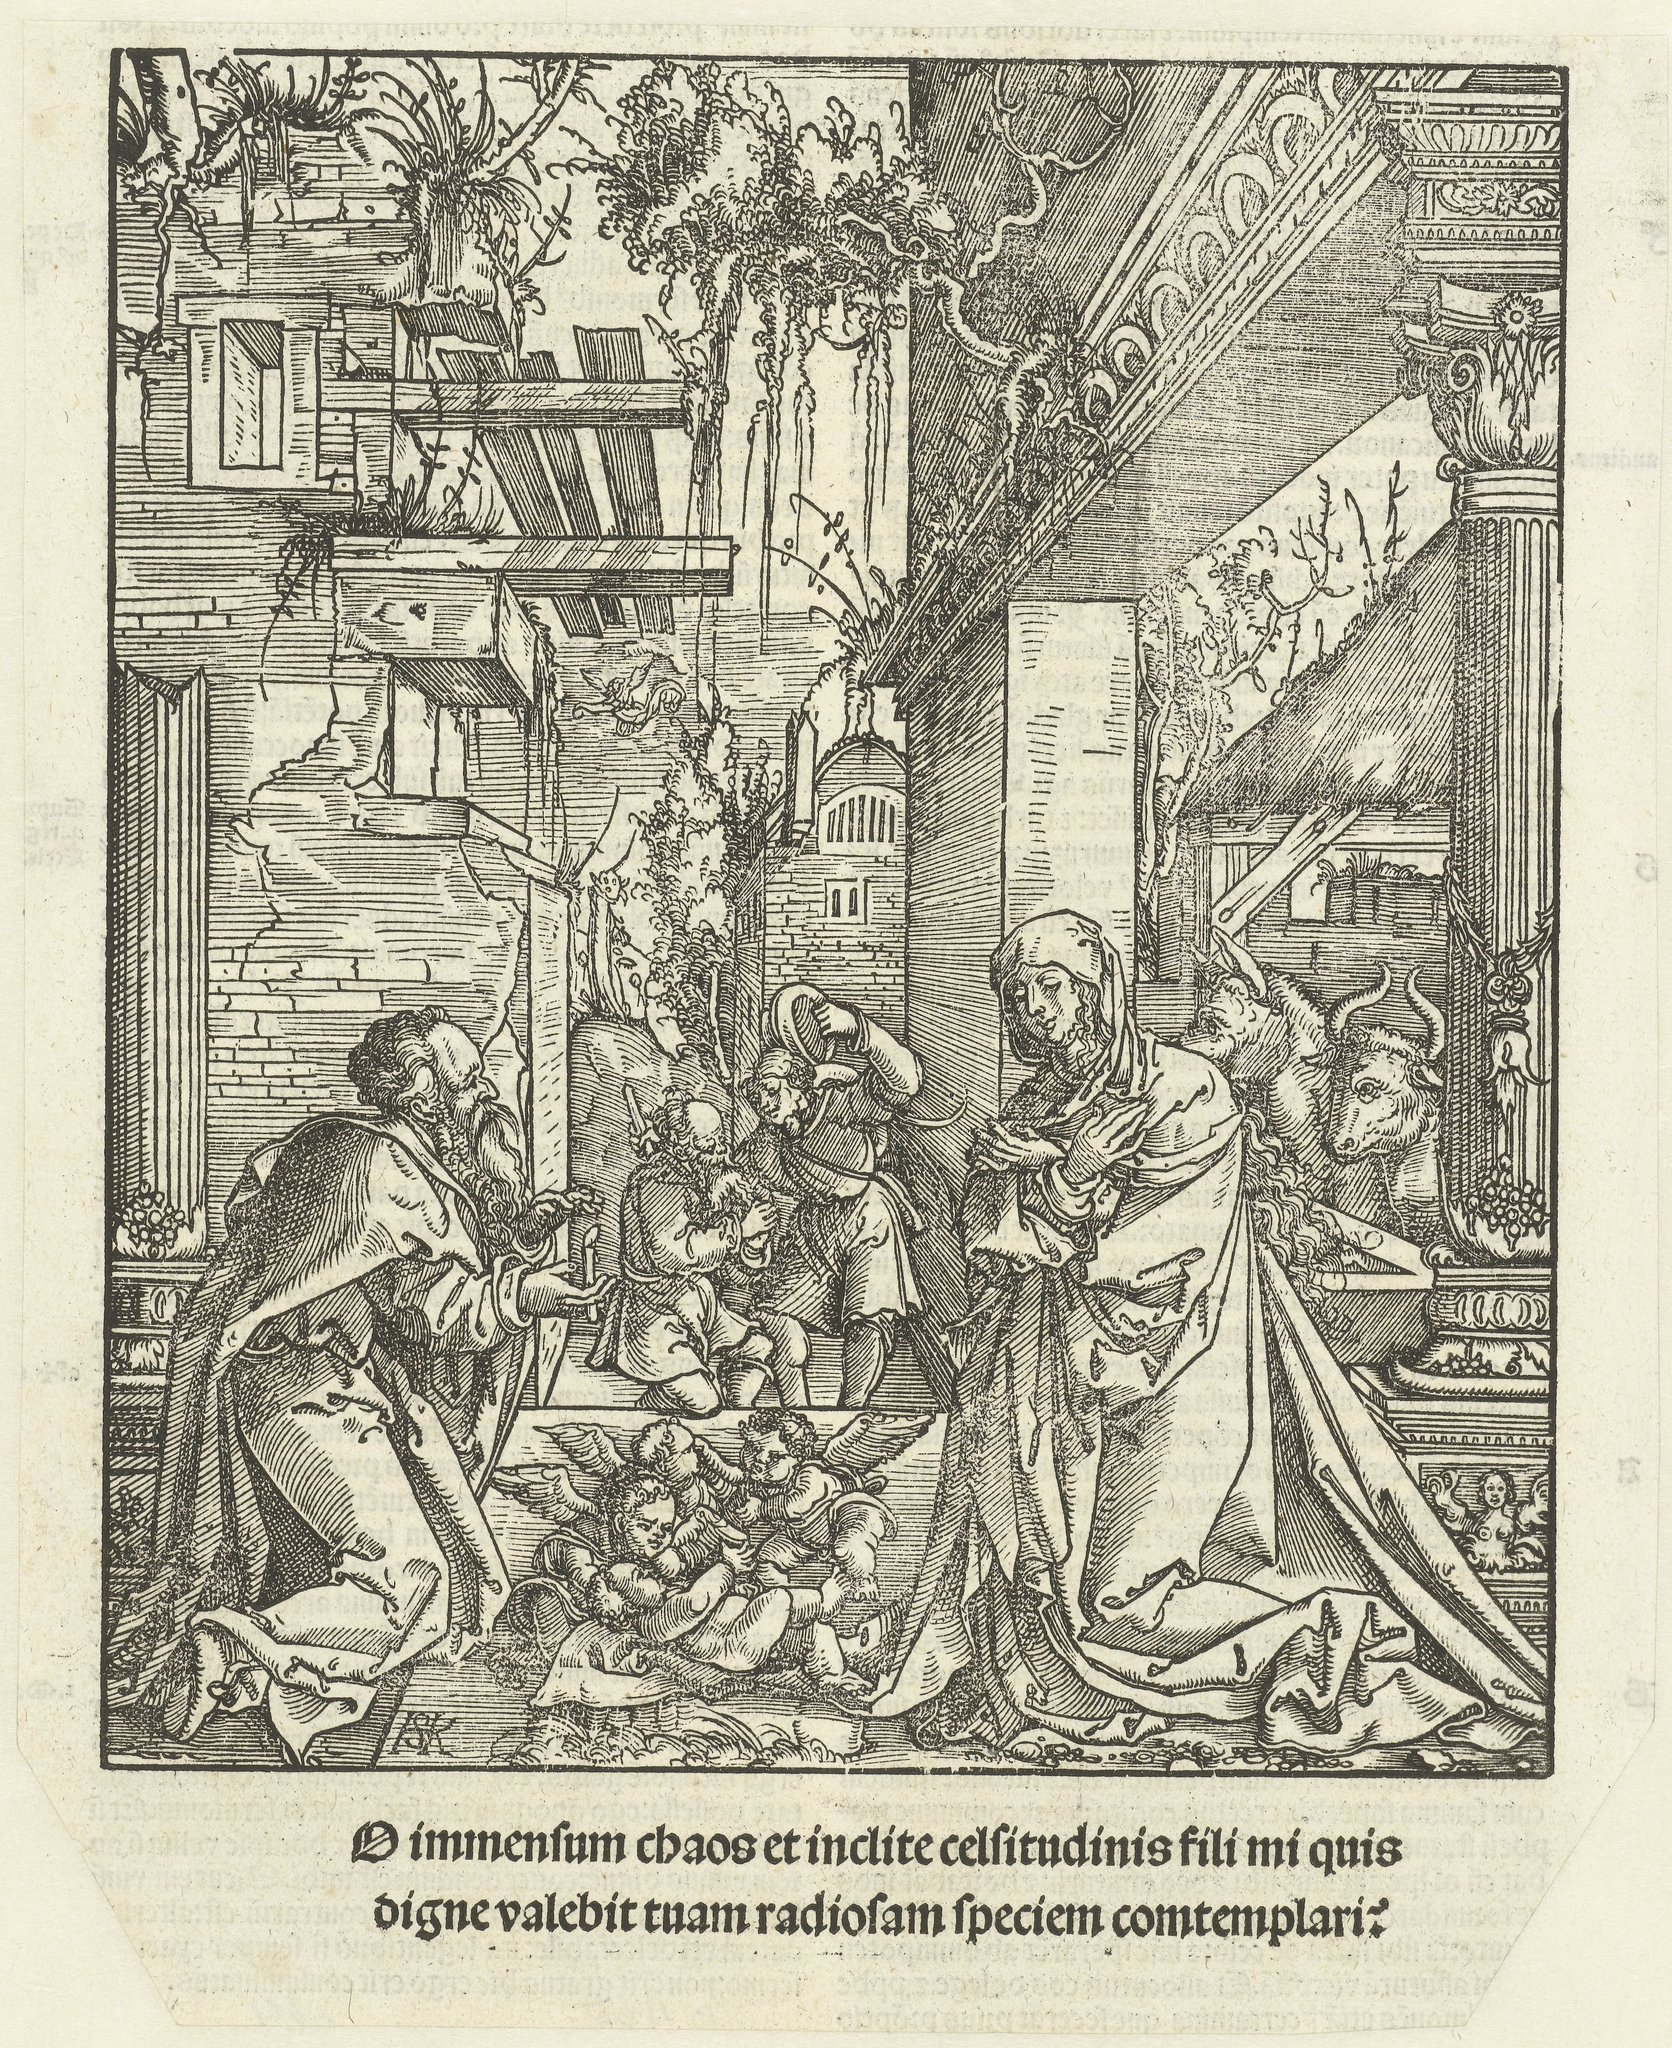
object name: book illustration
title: De geboorte van Christus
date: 1520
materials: paper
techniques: woodcut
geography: nuremberg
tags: adoration of the christ-child by the shepherds; mary and joseph present, adoration of the christ-child by mary and joseph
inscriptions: collector's mark: Lugt 2228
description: Maria en Jozef aanbidden geknield het Christuskind, dat tussen hen in in een bouwvallige ruimte ligt. Achter hen komen enkele herders binnen. Op de achtergrond rechts de os en de ezel. Onder de voorstelling twee regels Latijnse tekst in gotisch schrift. Gehele versozijde bedrukt met Latijnse bijbeltekst in gotisch schrift.